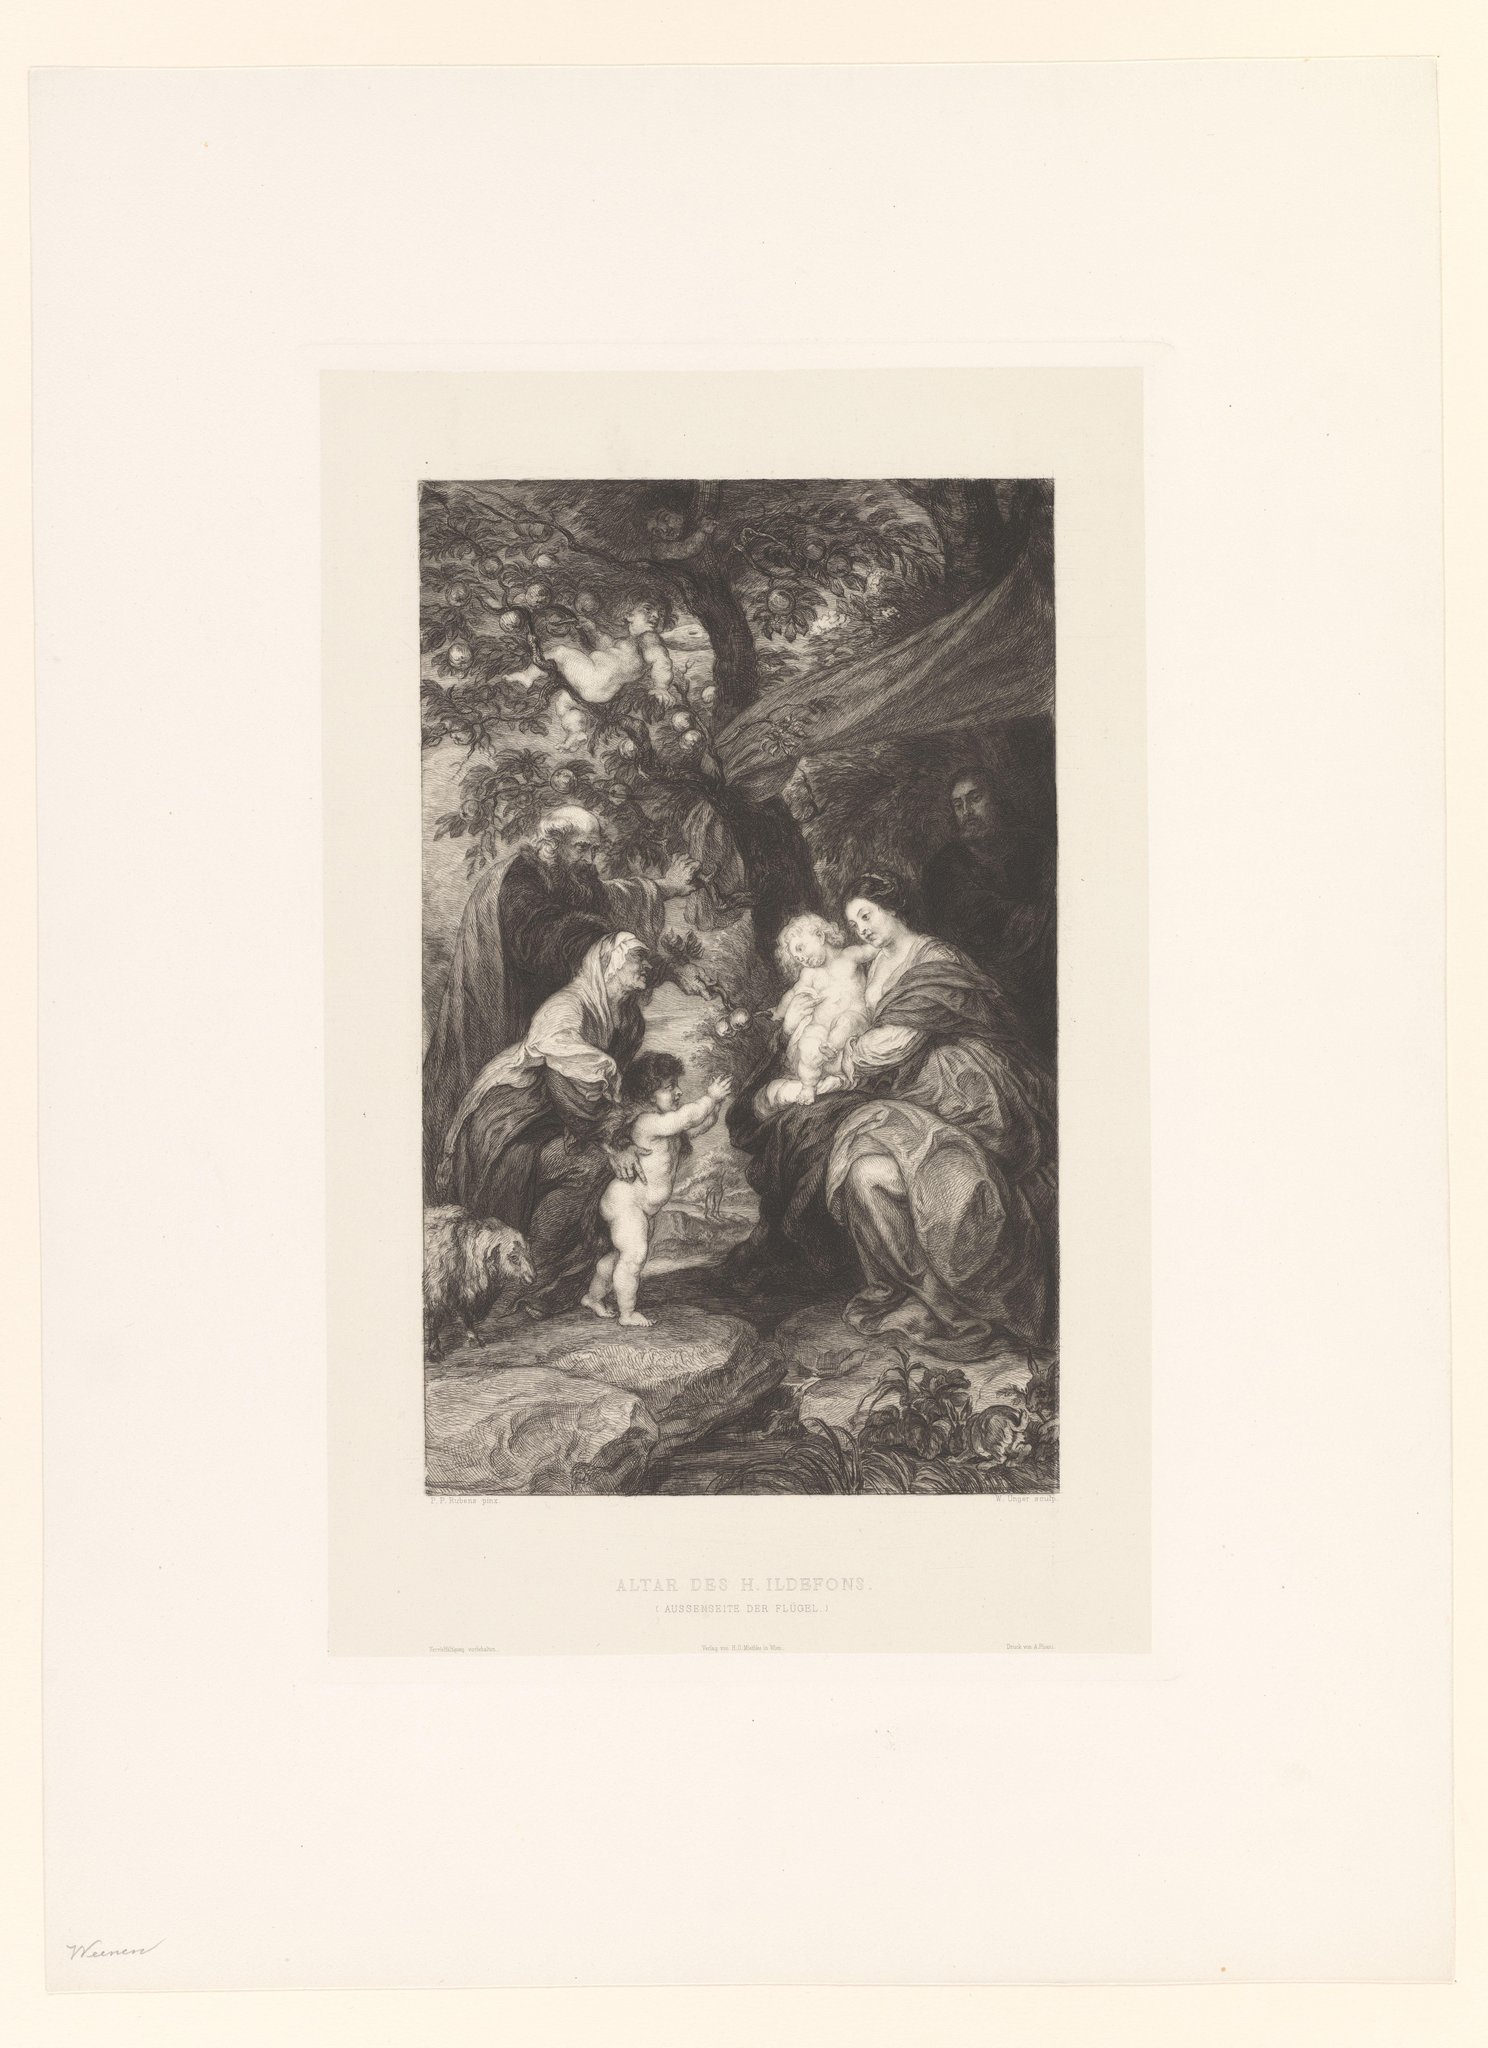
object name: print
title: Altar des H. Ildefons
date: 1861-1889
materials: paper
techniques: etching, intaglio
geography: vienna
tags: trees: apple-tree, holy family, and derived representations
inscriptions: collector's mark: Lugt 2228